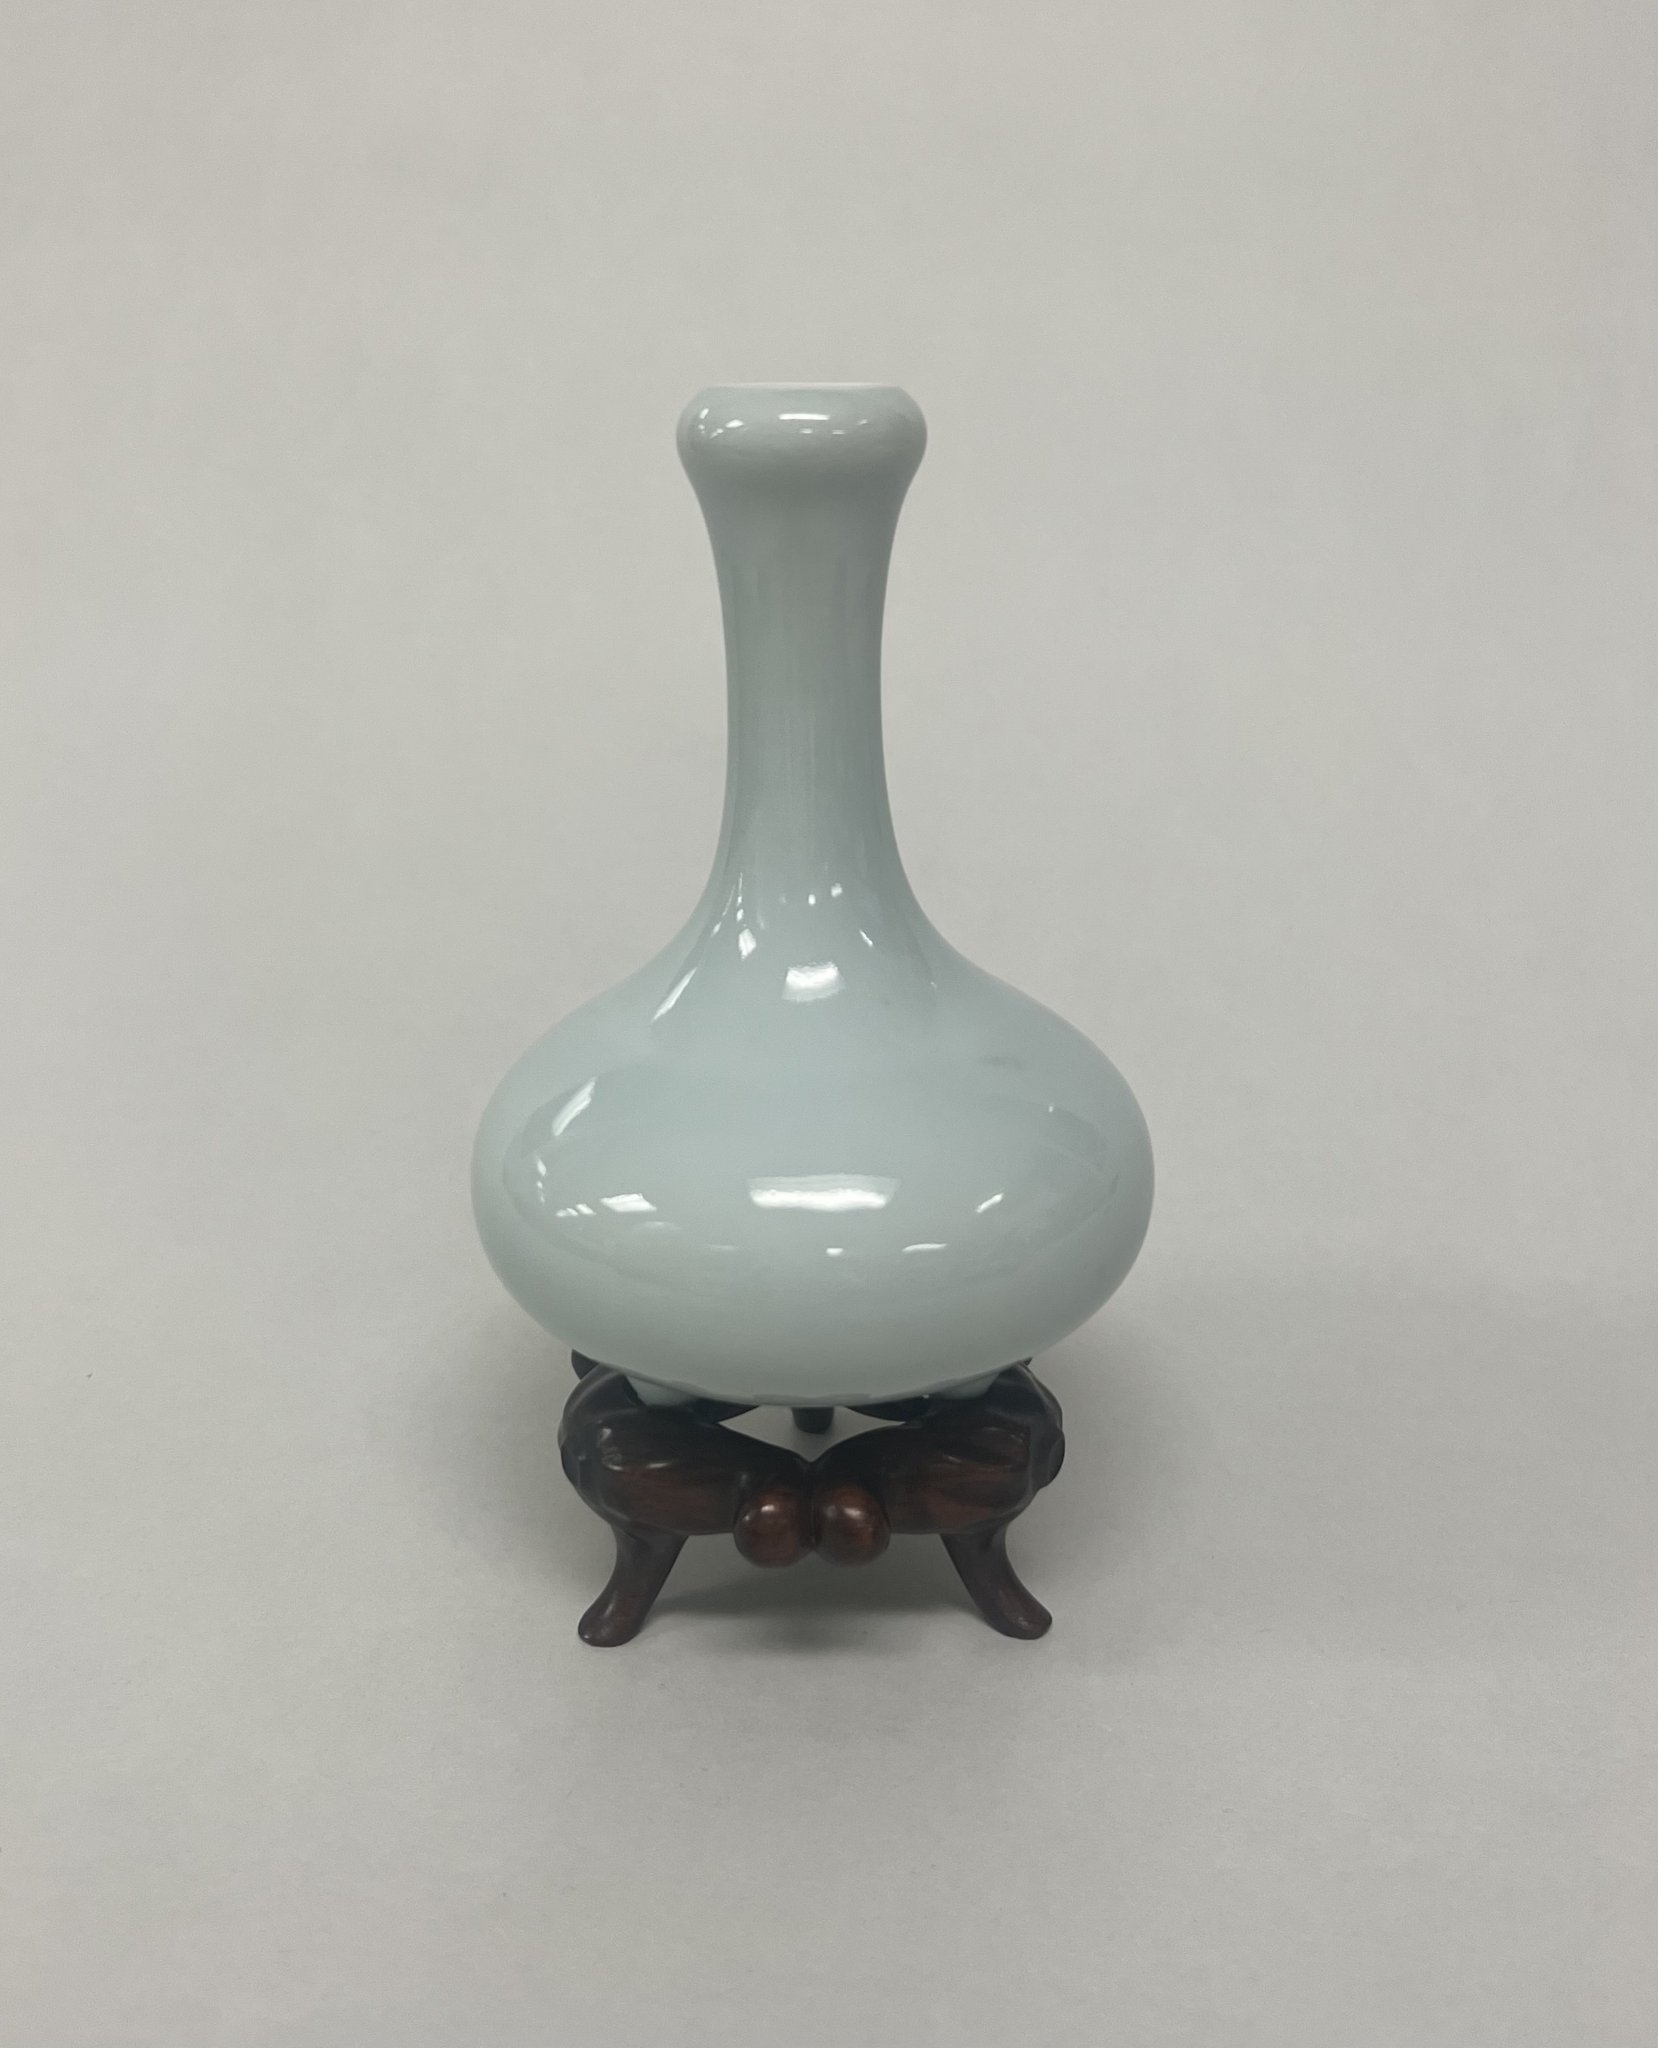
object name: vase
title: Tripod vase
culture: chinese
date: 1767-1800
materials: glaze, porcelain